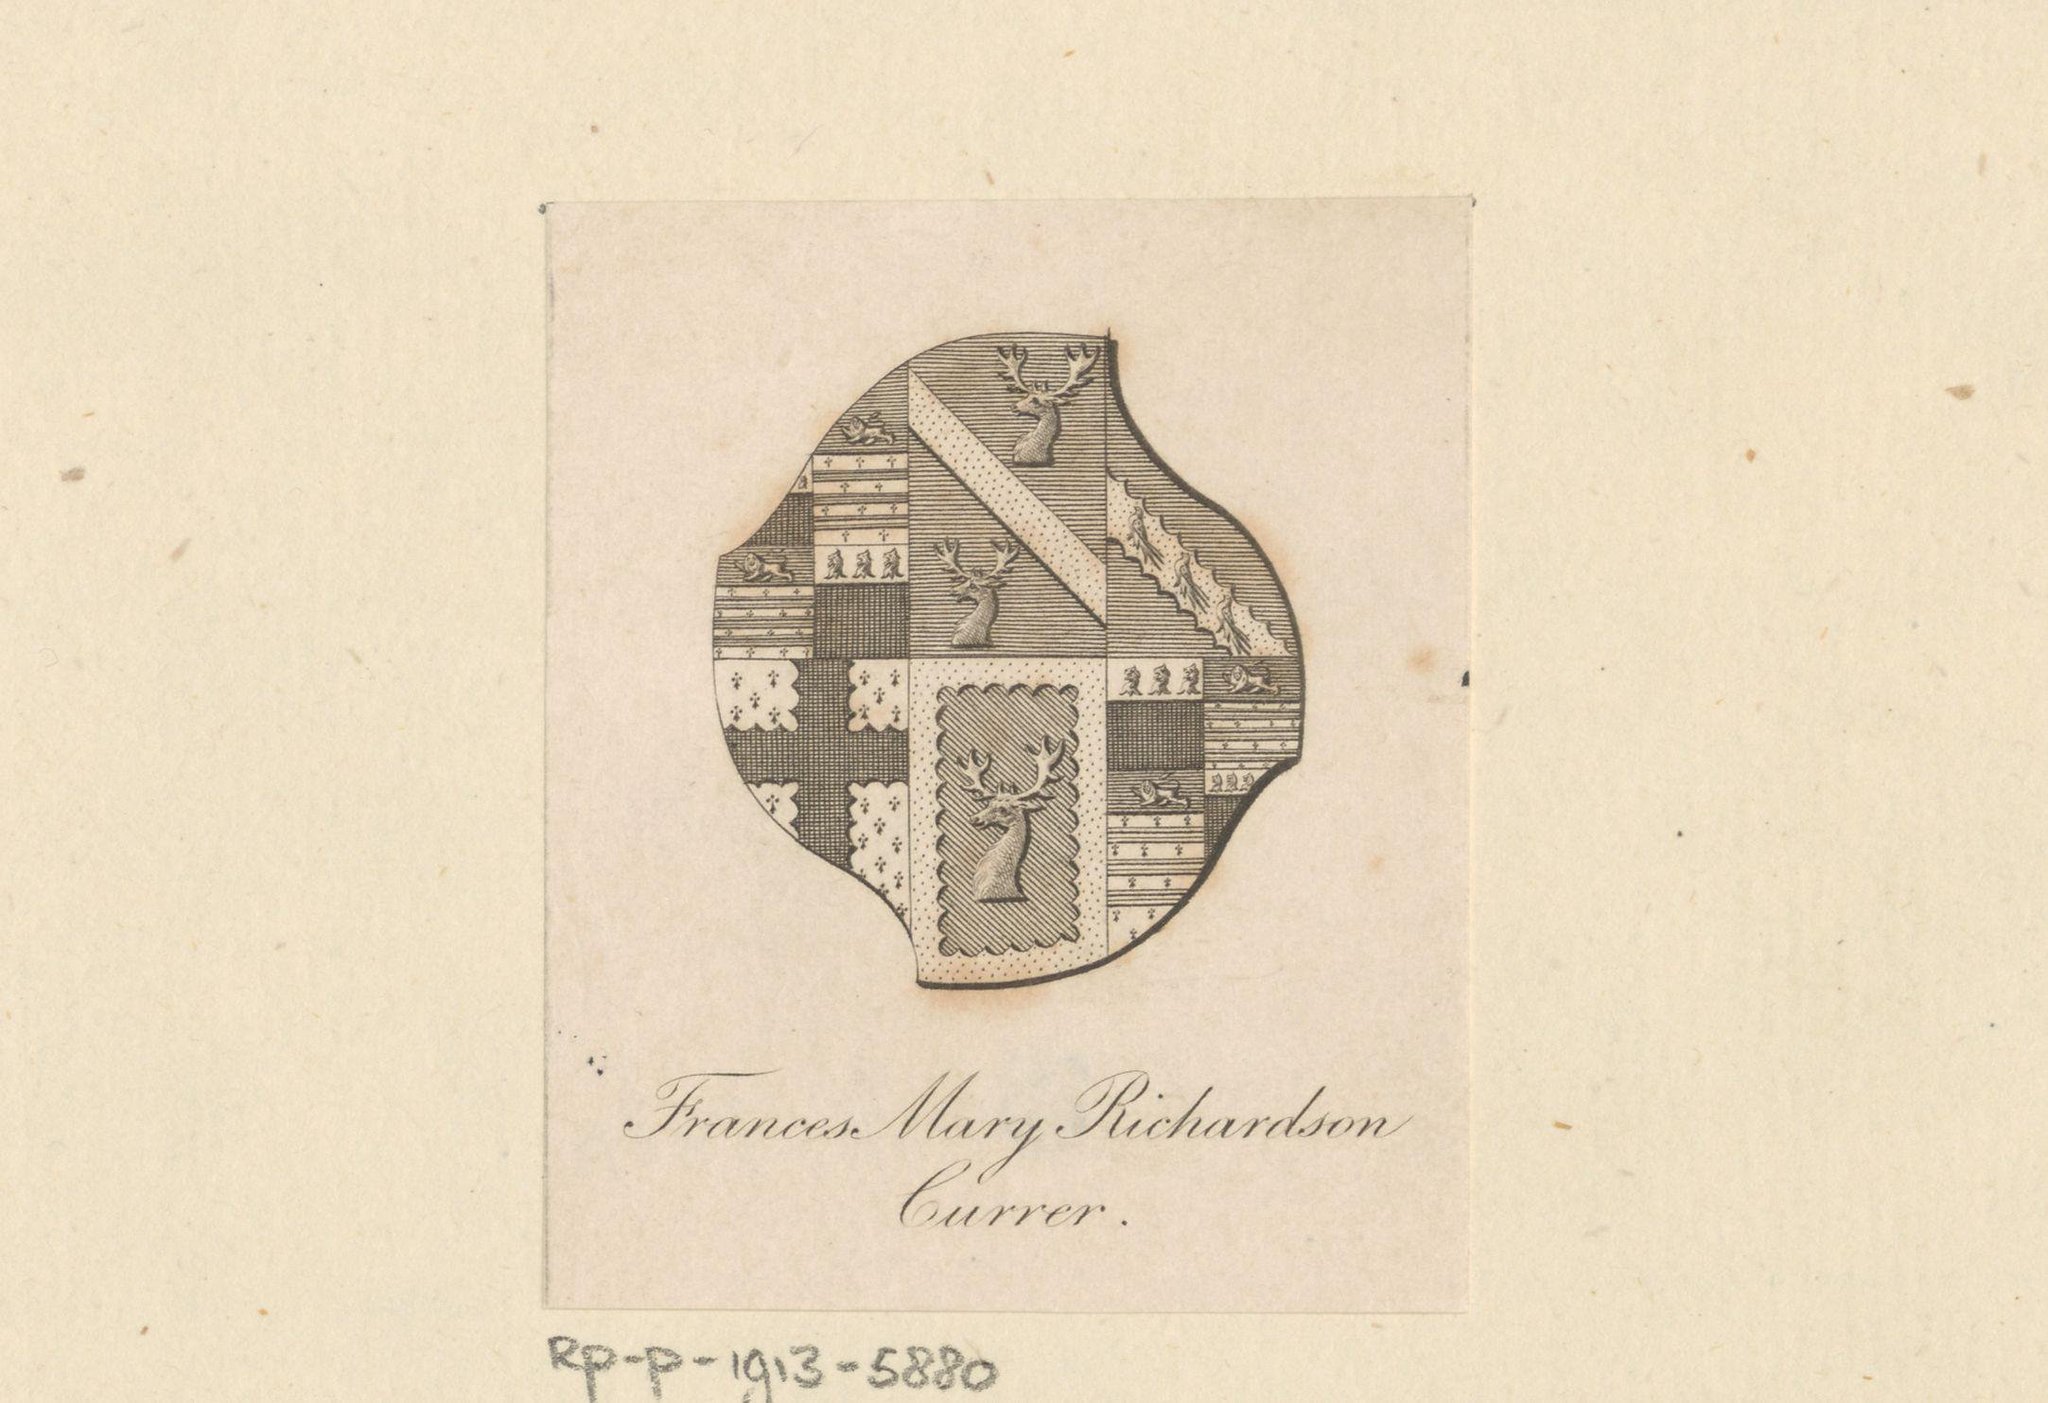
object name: bookplate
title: Ex libris van Frances Mary Richardson Currer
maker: Anonymous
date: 1795-1861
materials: paper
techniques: engraving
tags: armorial bearing, heraldry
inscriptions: collector's mark: Lugt 2760, collector's mark: Lugt 2233